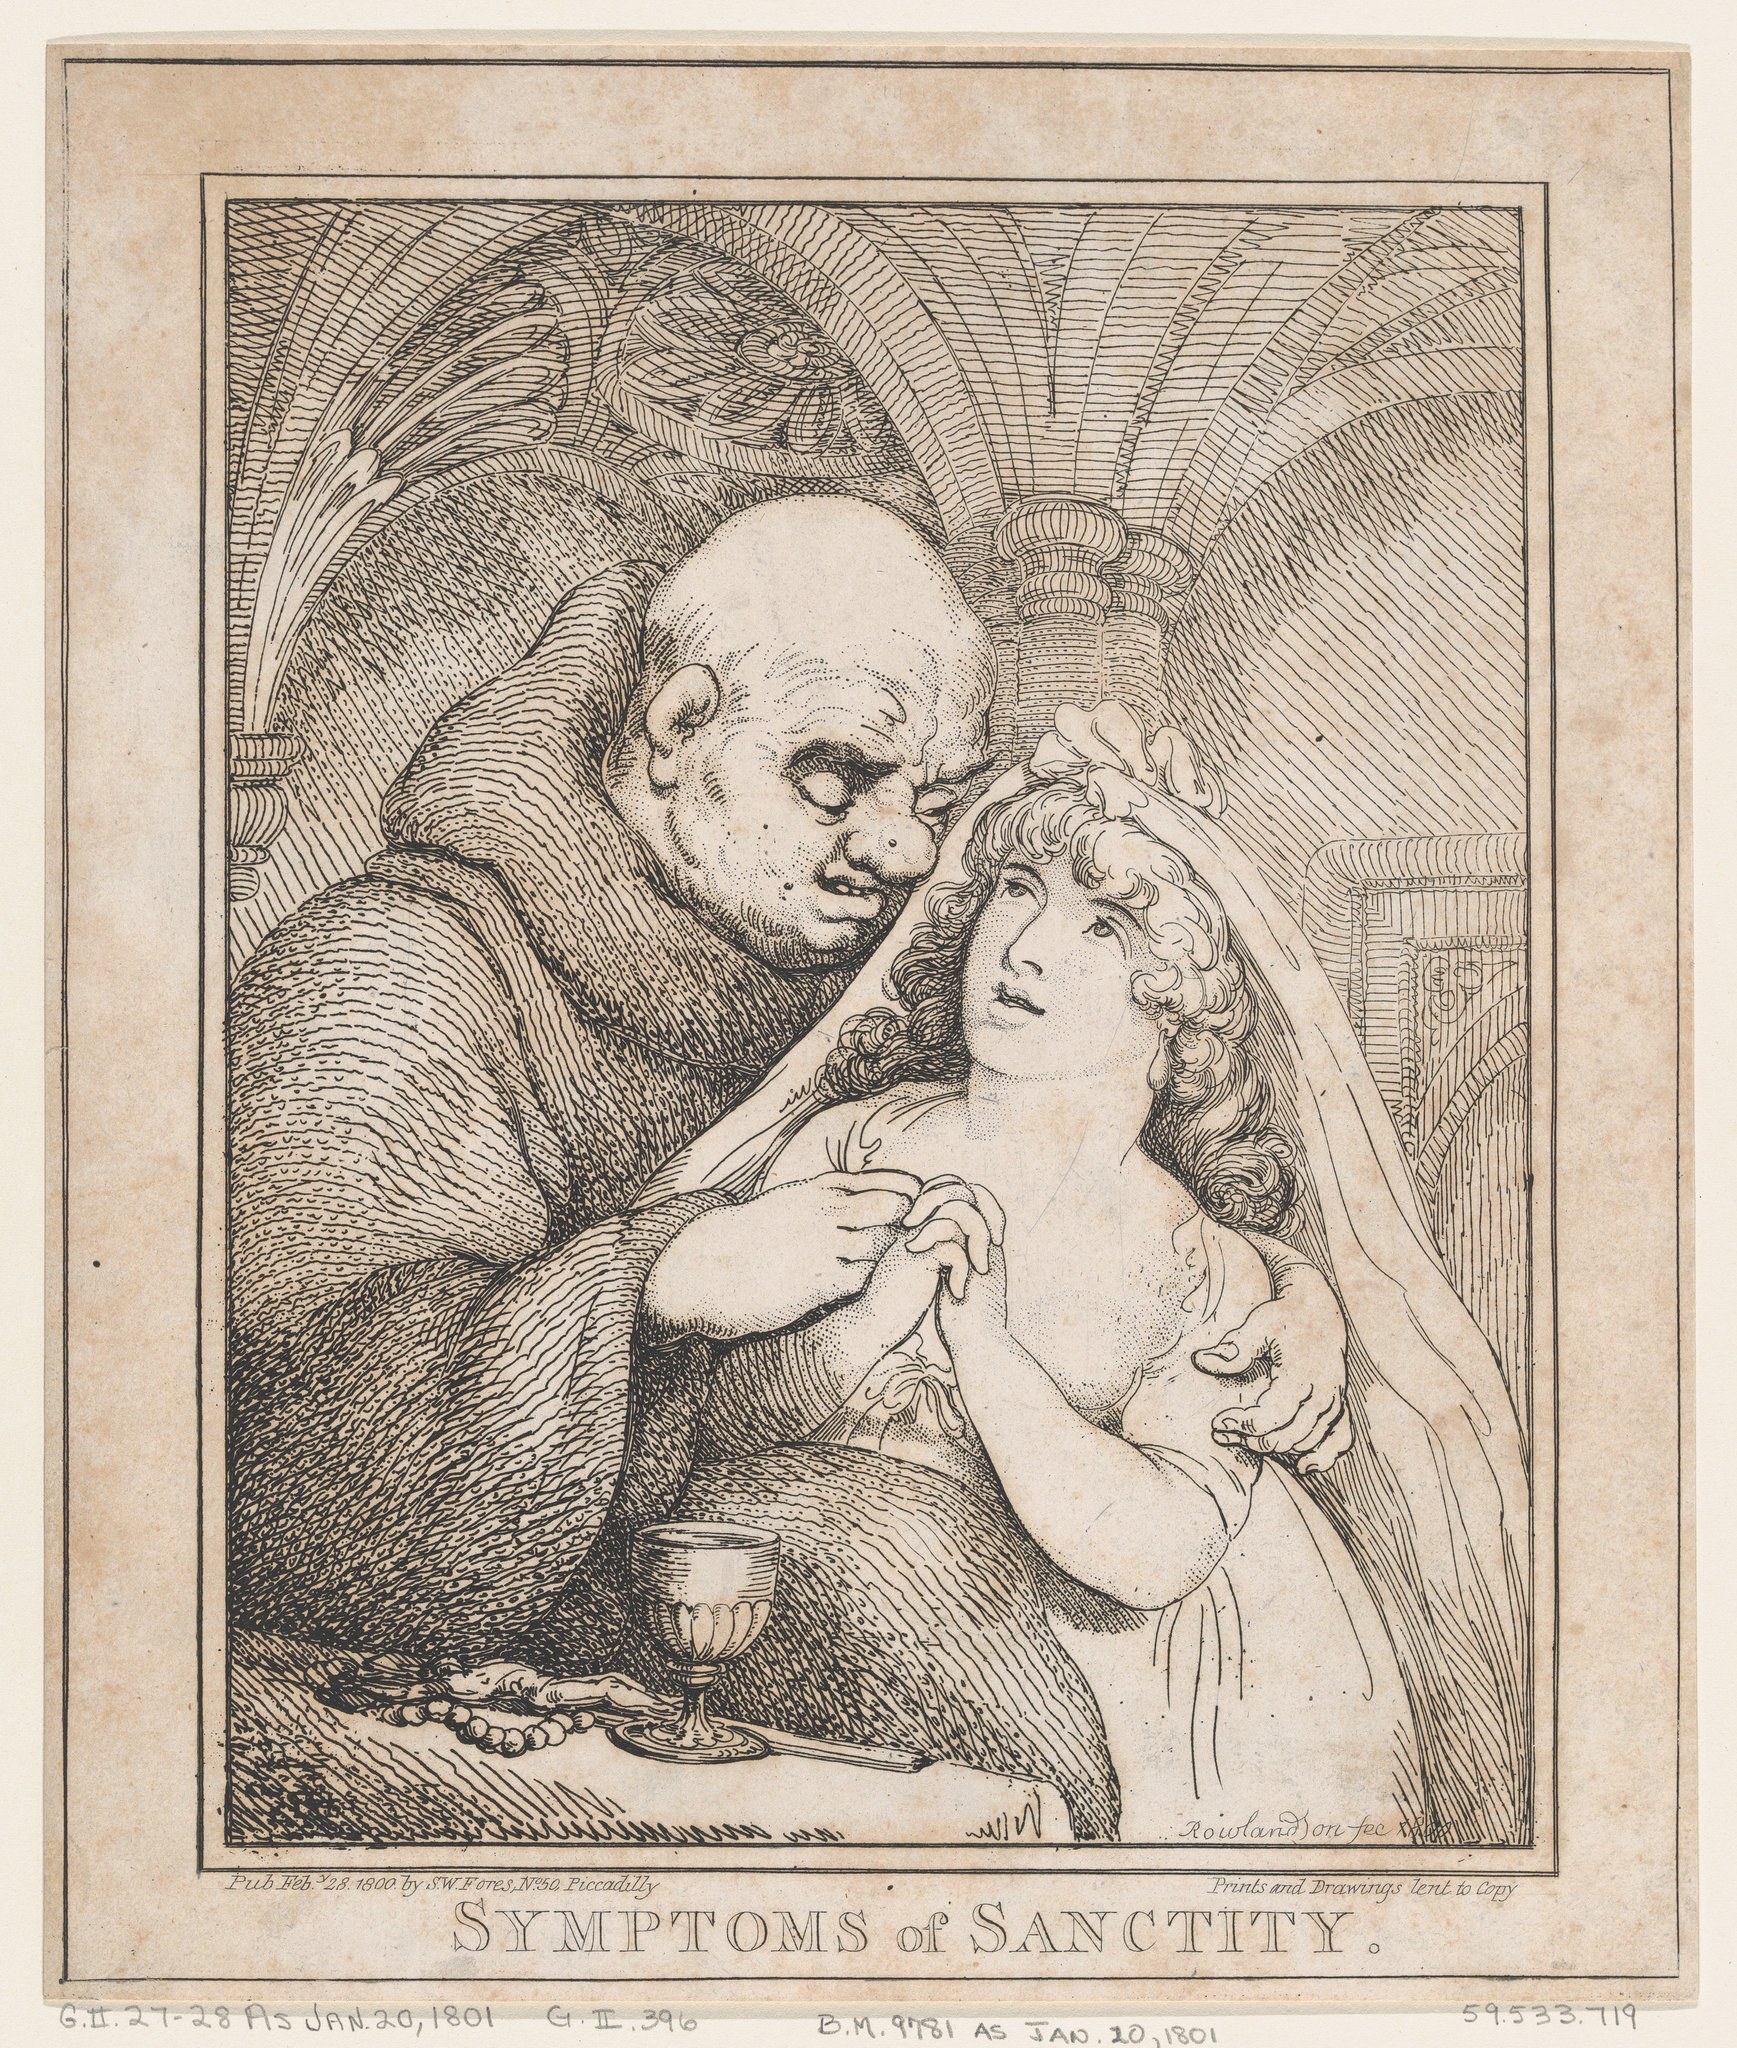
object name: print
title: Symptoms of Sanctity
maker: thomas rowlandson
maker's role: artist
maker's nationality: british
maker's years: 1757-1827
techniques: etching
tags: men,women